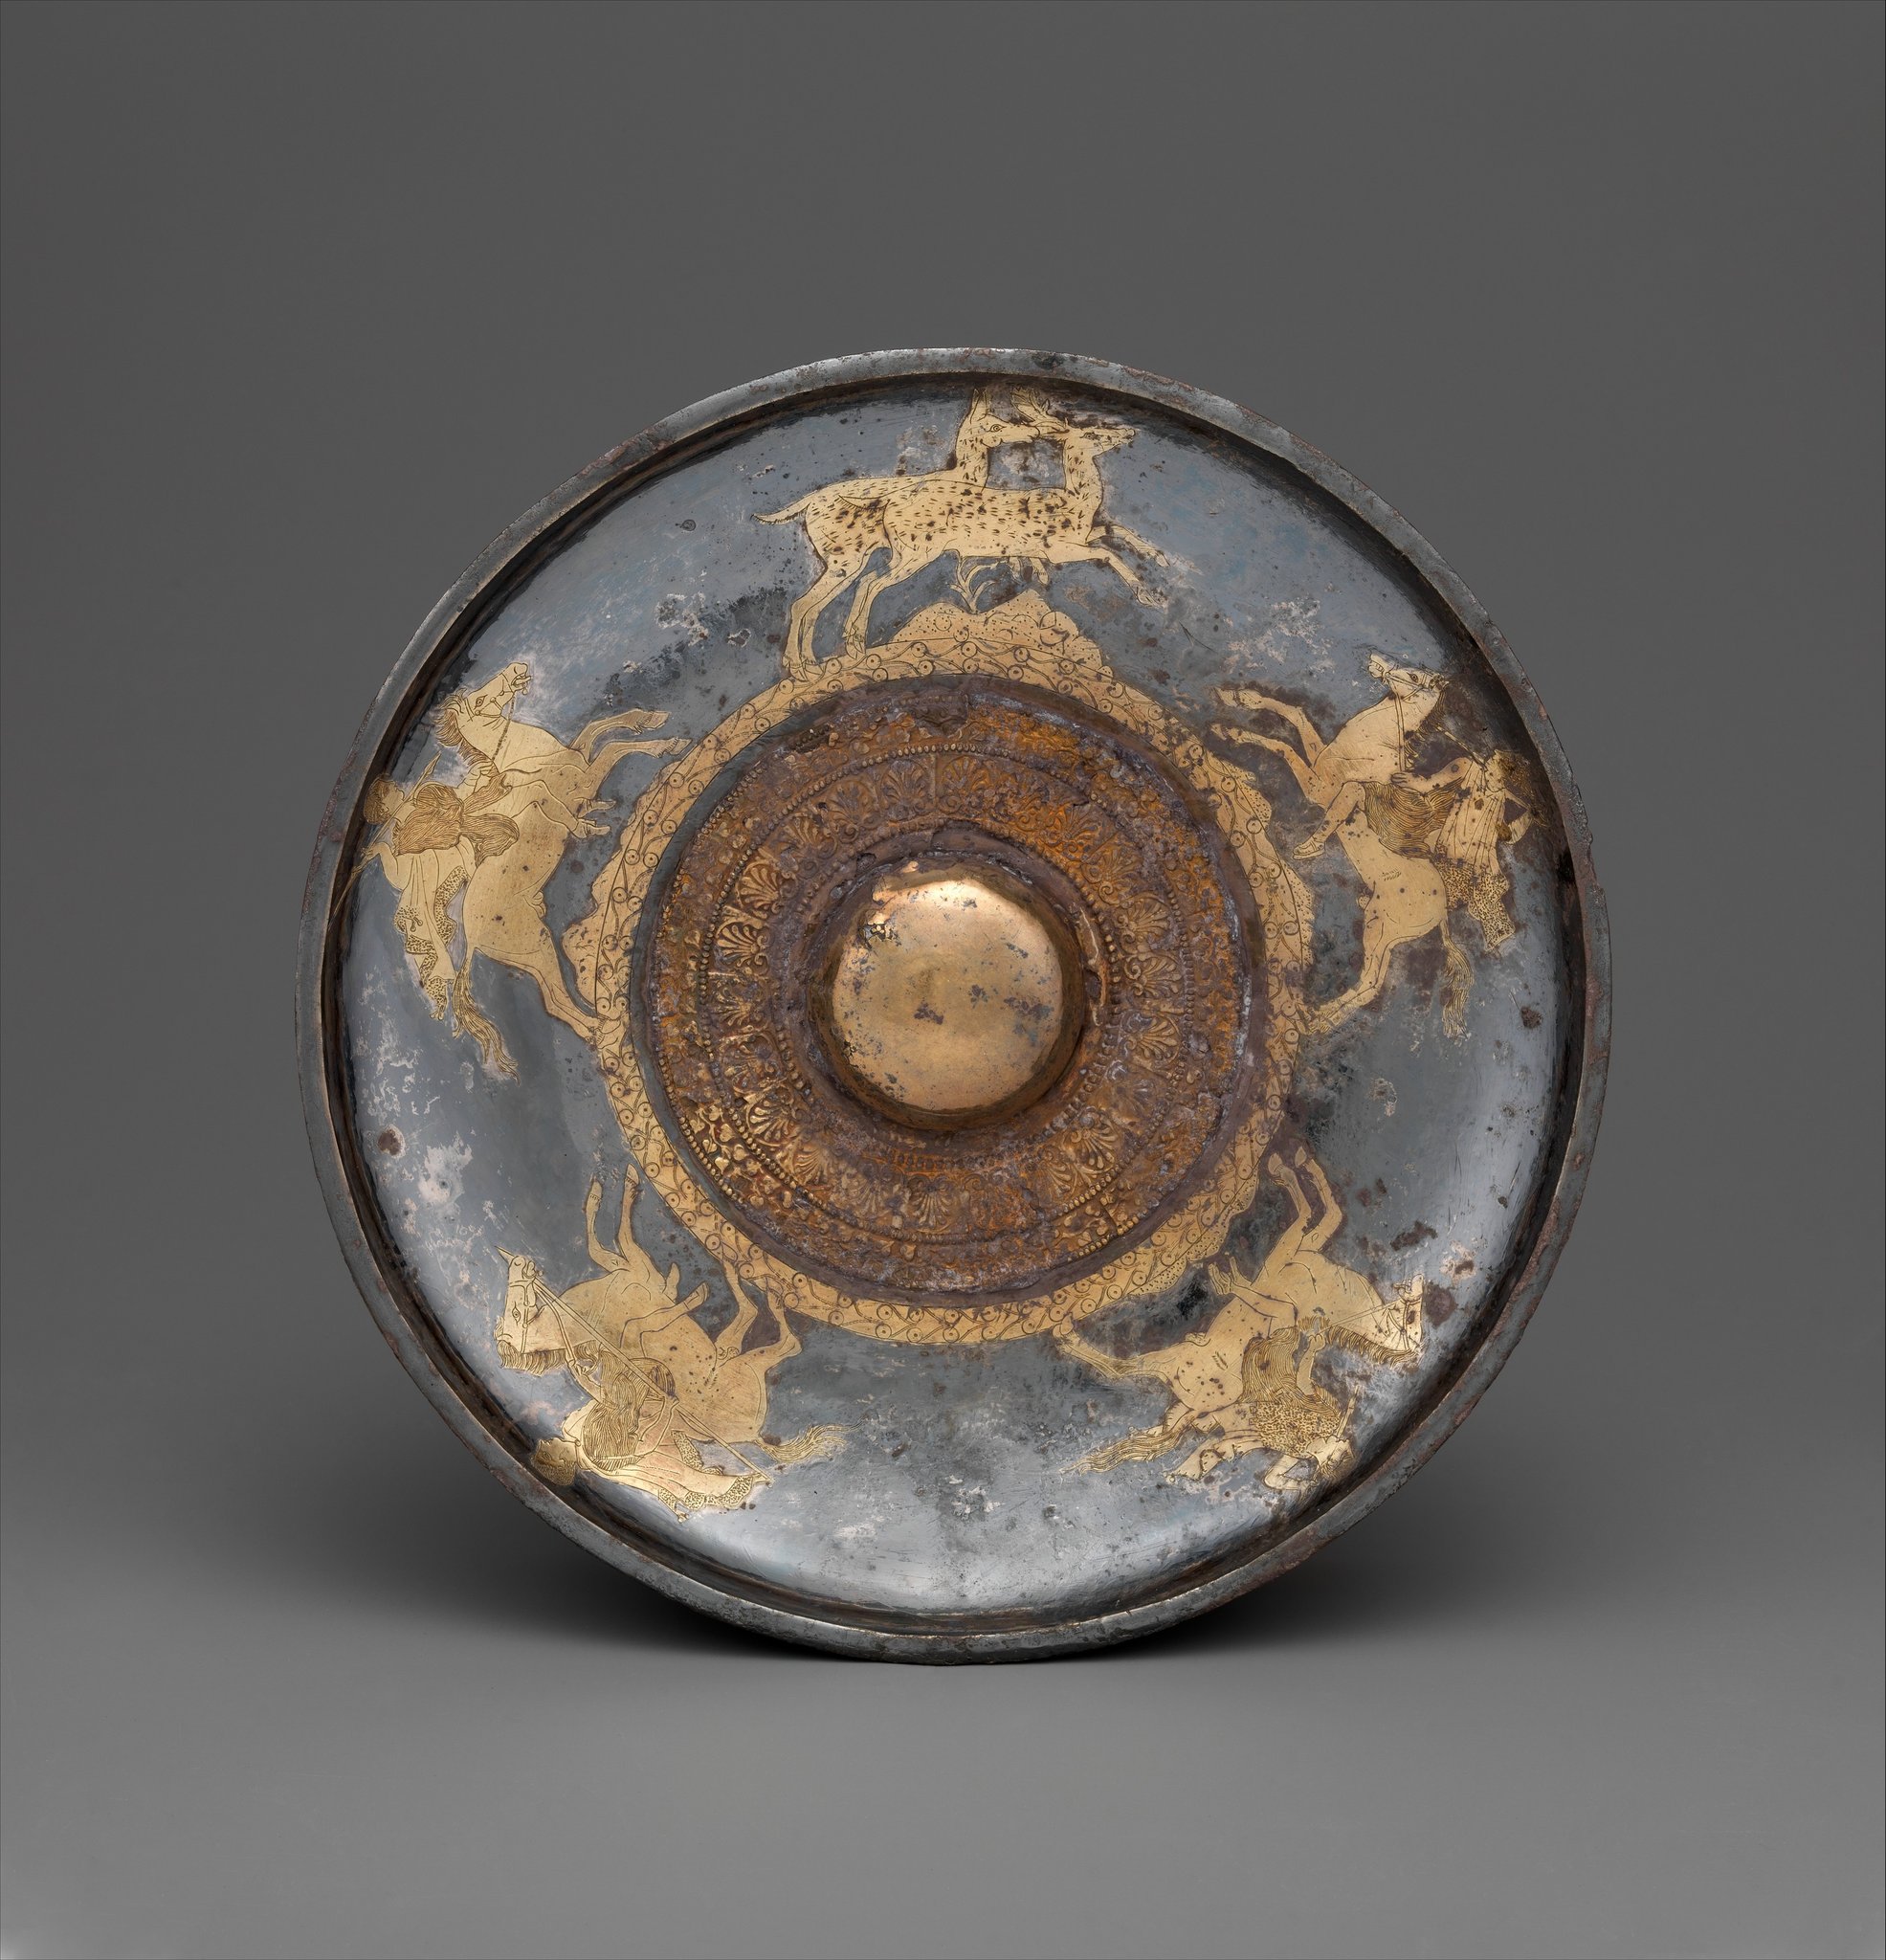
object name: phiale mesomphalos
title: Gilt silver phiale mesomphalos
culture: greek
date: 434-401 BCE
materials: silver gilt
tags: hunting,deer,horses